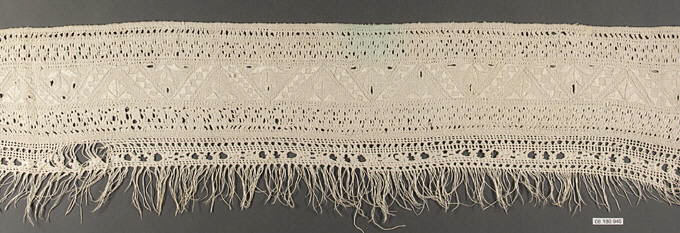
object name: border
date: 1801-1900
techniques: embroidery